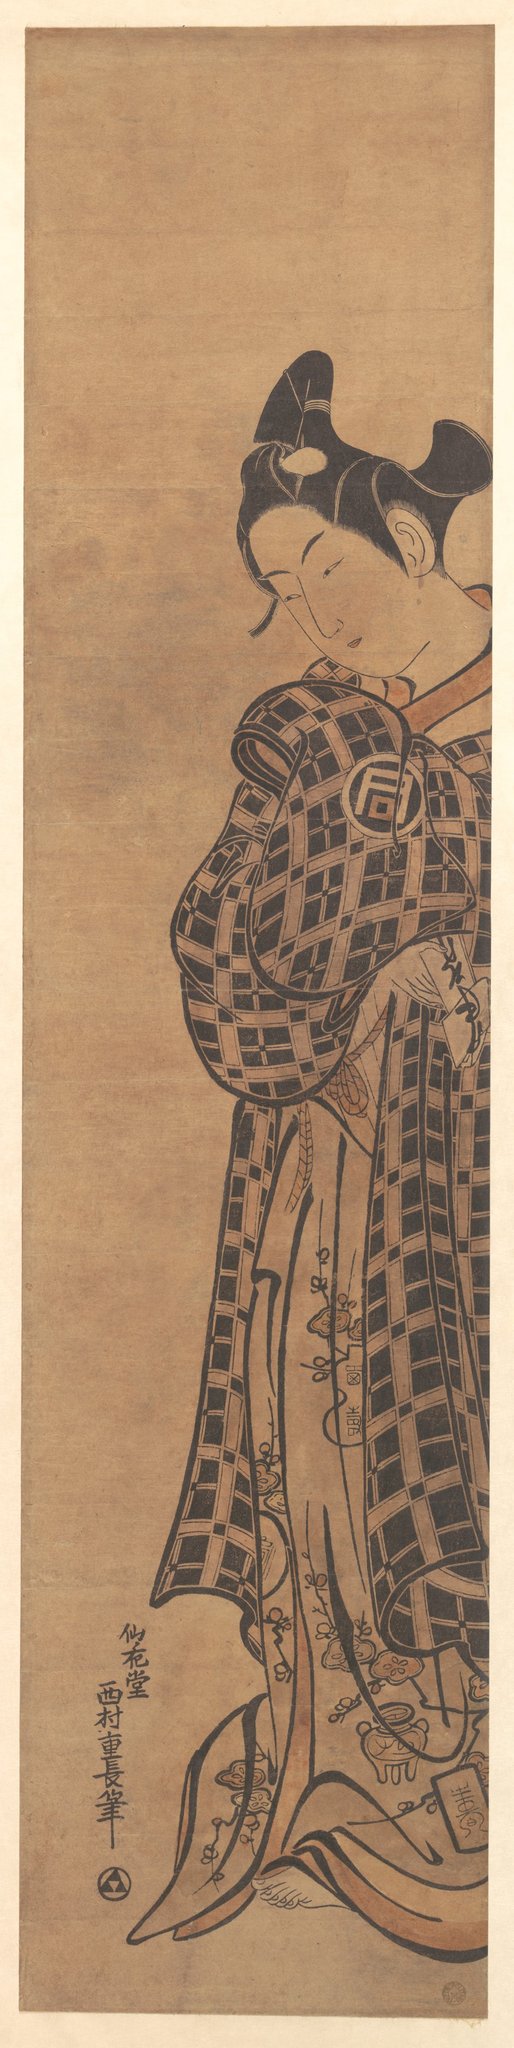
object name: print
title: The Actor Sanogawa Ichimatsu as a Young Man Holding a Folded Letter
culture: japanese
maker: nishimura shigenaga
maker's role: artist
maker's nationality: japanese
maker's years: 1697-1756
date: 1765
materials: ink, paper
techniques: woodblock print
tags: men,actors